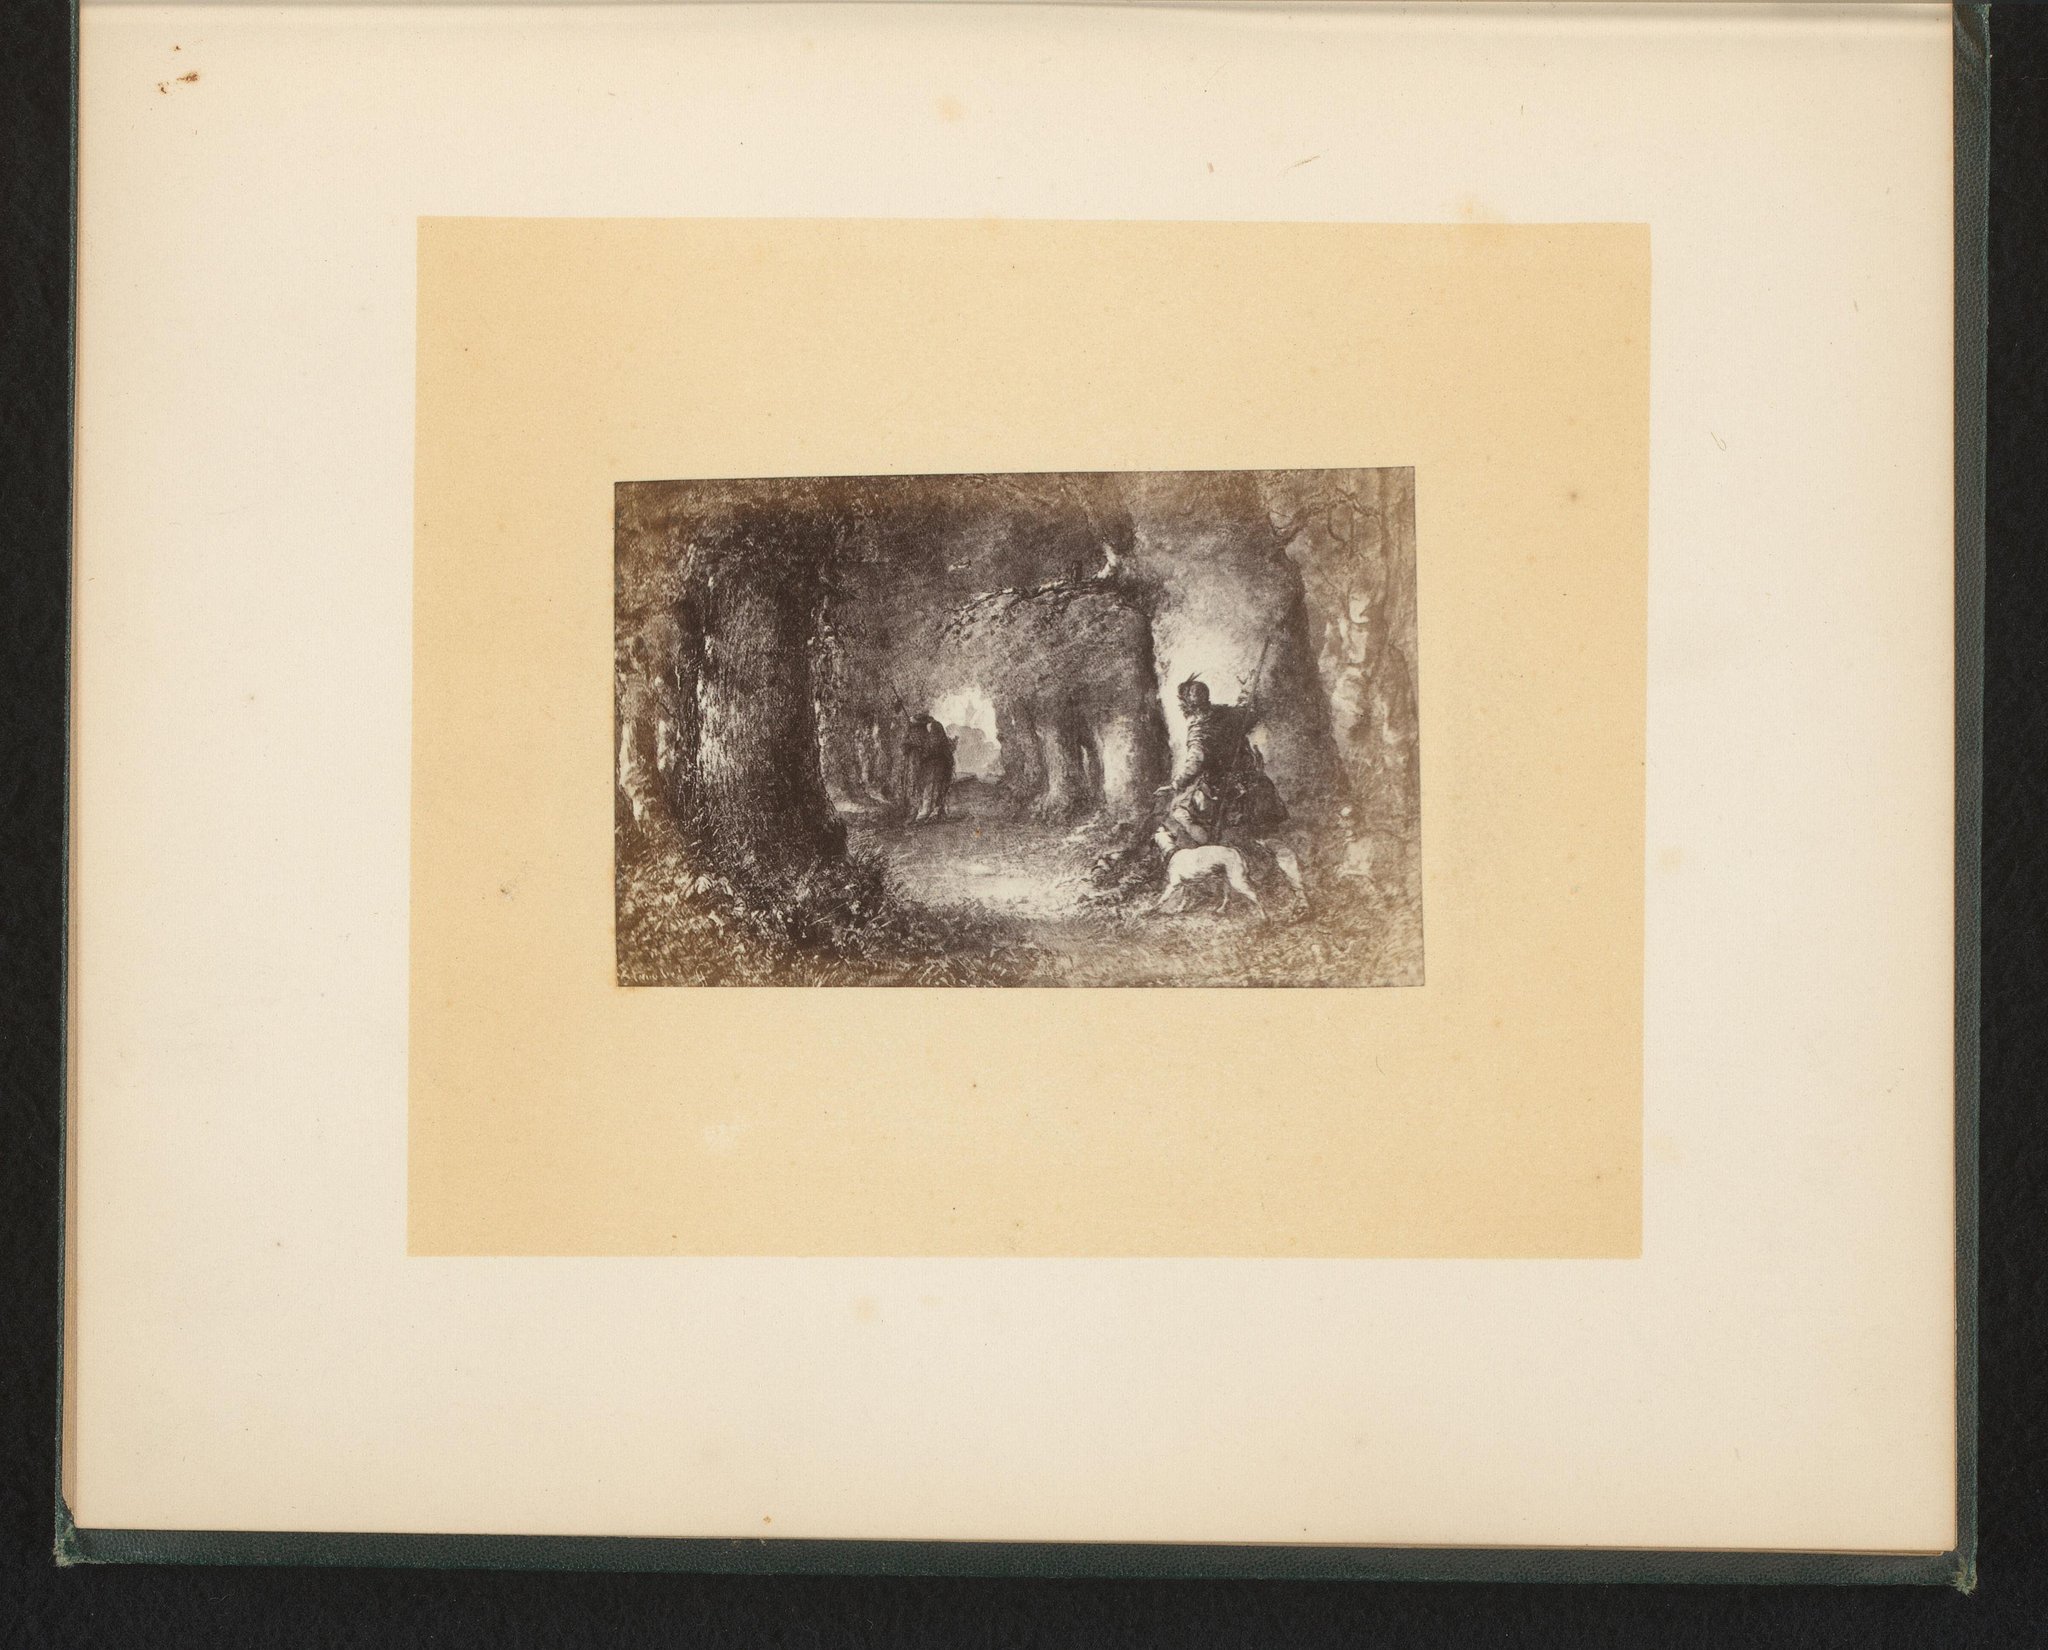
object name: reproduction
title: Fotoreproductie van een schilderij ter illustratie van Van Lenneps Het Godsoordeel door Johannes Stroebel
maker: Anonymous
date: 1870-1880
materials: paper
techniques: albumen print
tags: picture, painting